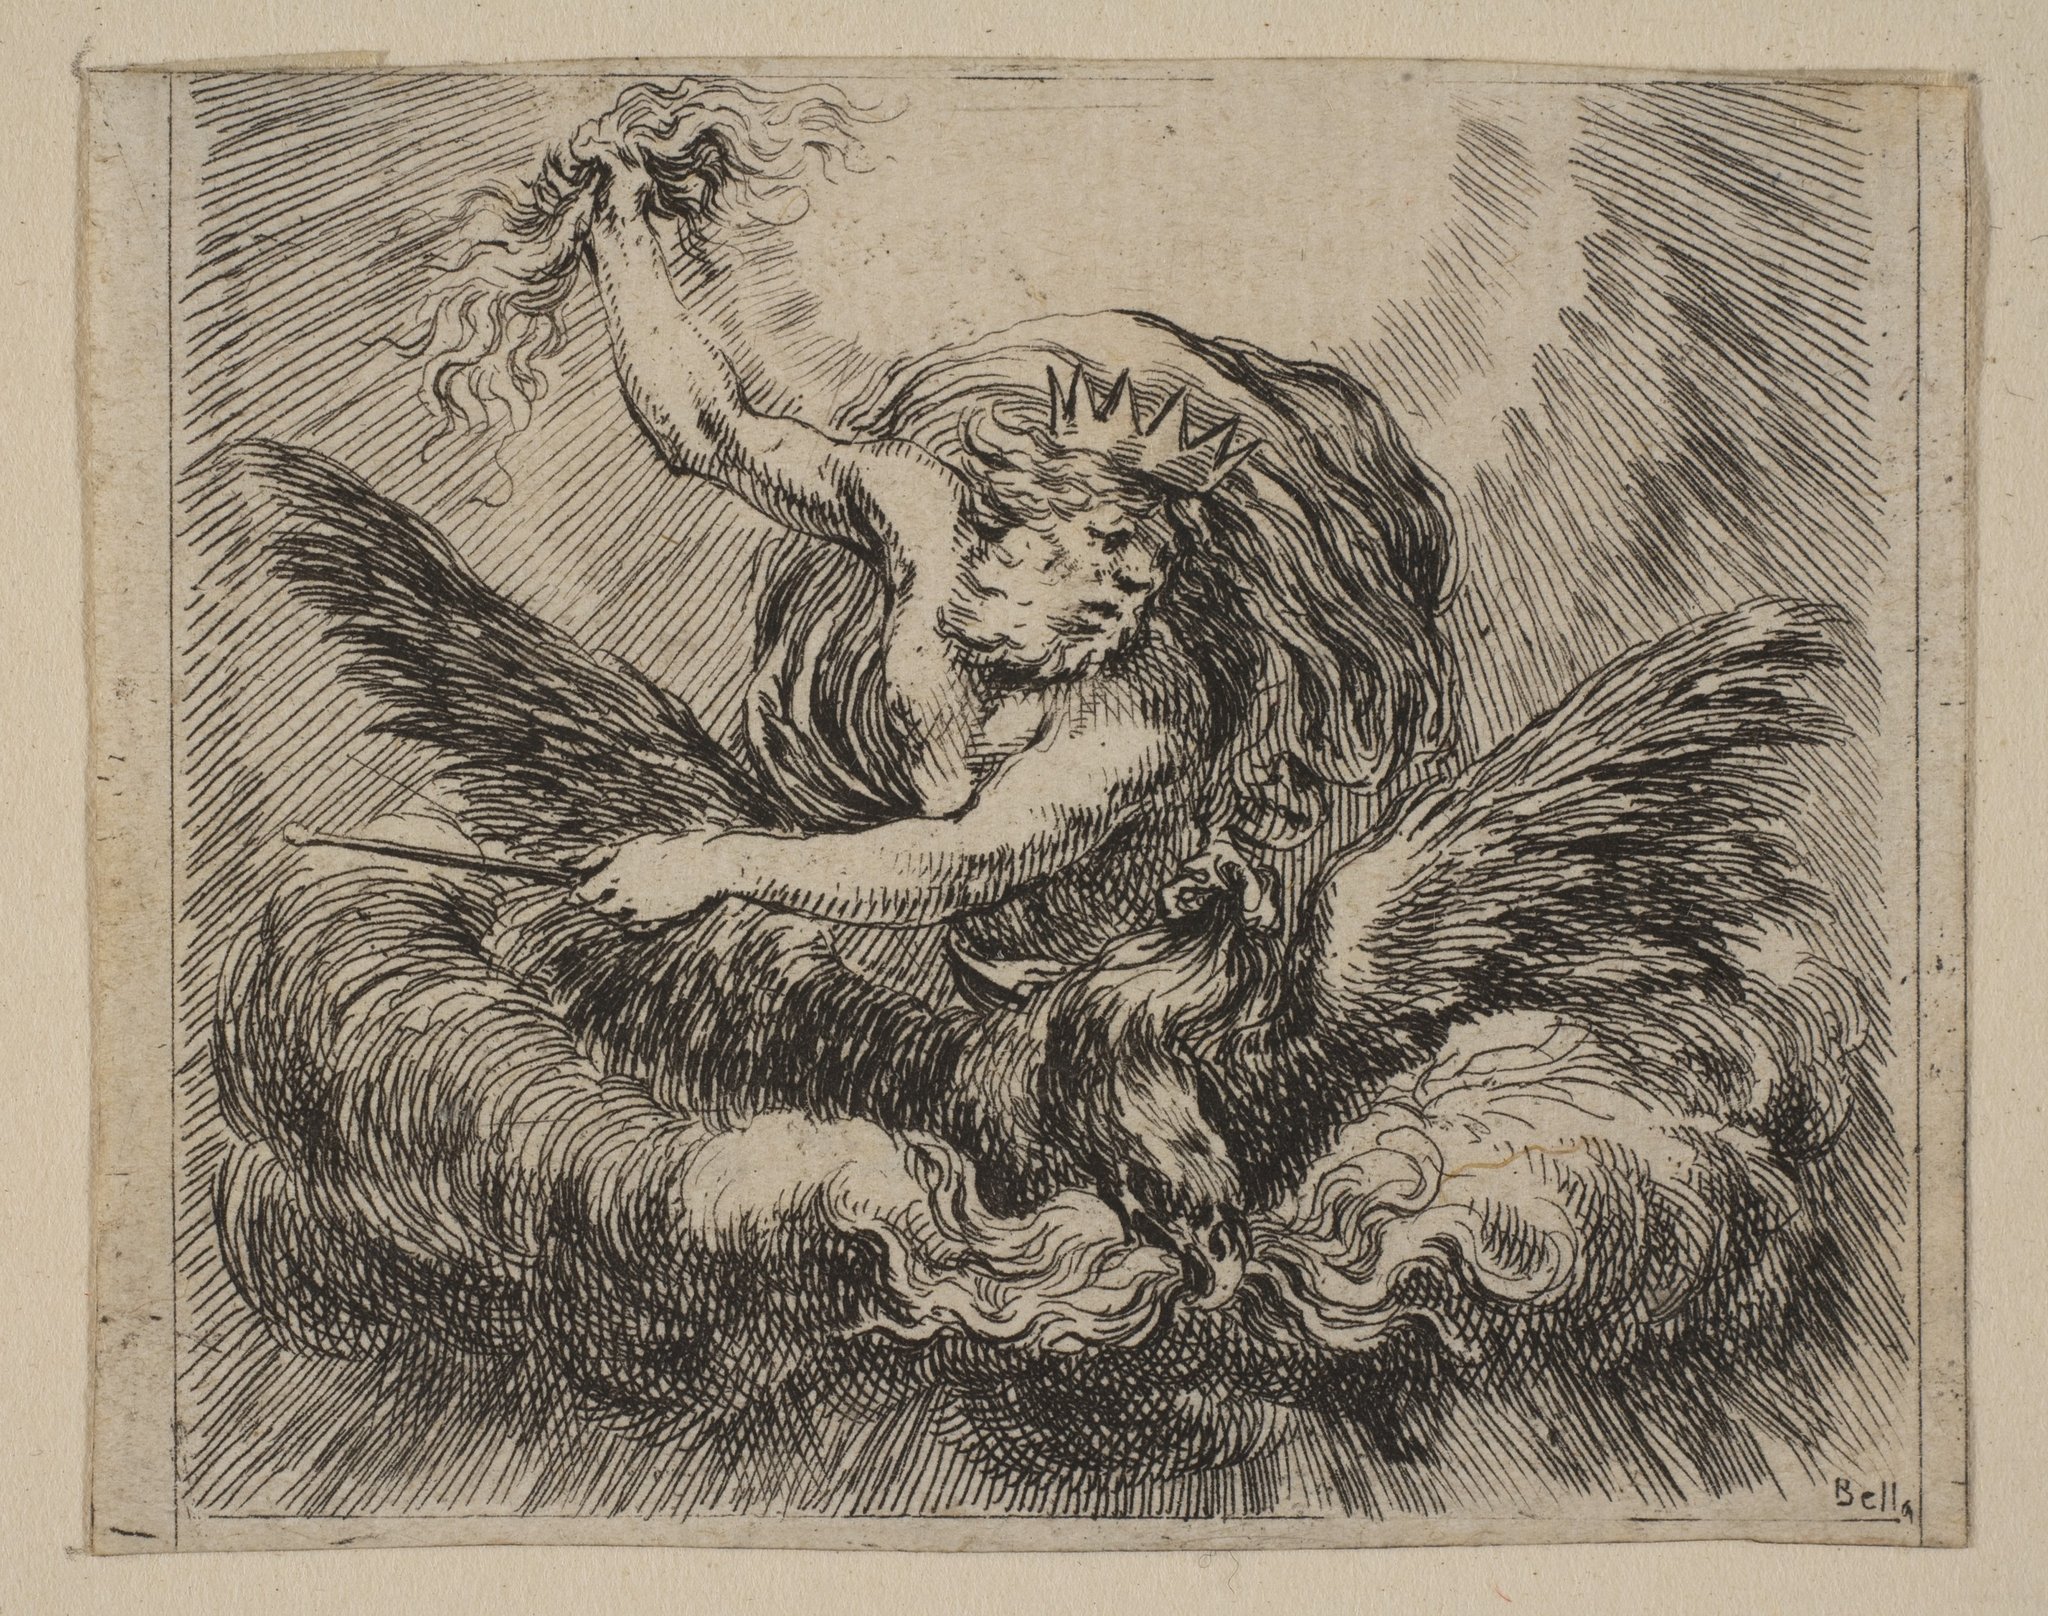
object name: print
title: Jupiter, from 'Game of Mythology' (Jeu de la Mythologie)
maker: stefano della bella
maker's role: artist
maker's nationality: italian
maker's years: 1610-1664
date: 1644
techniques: etching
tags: jupiter